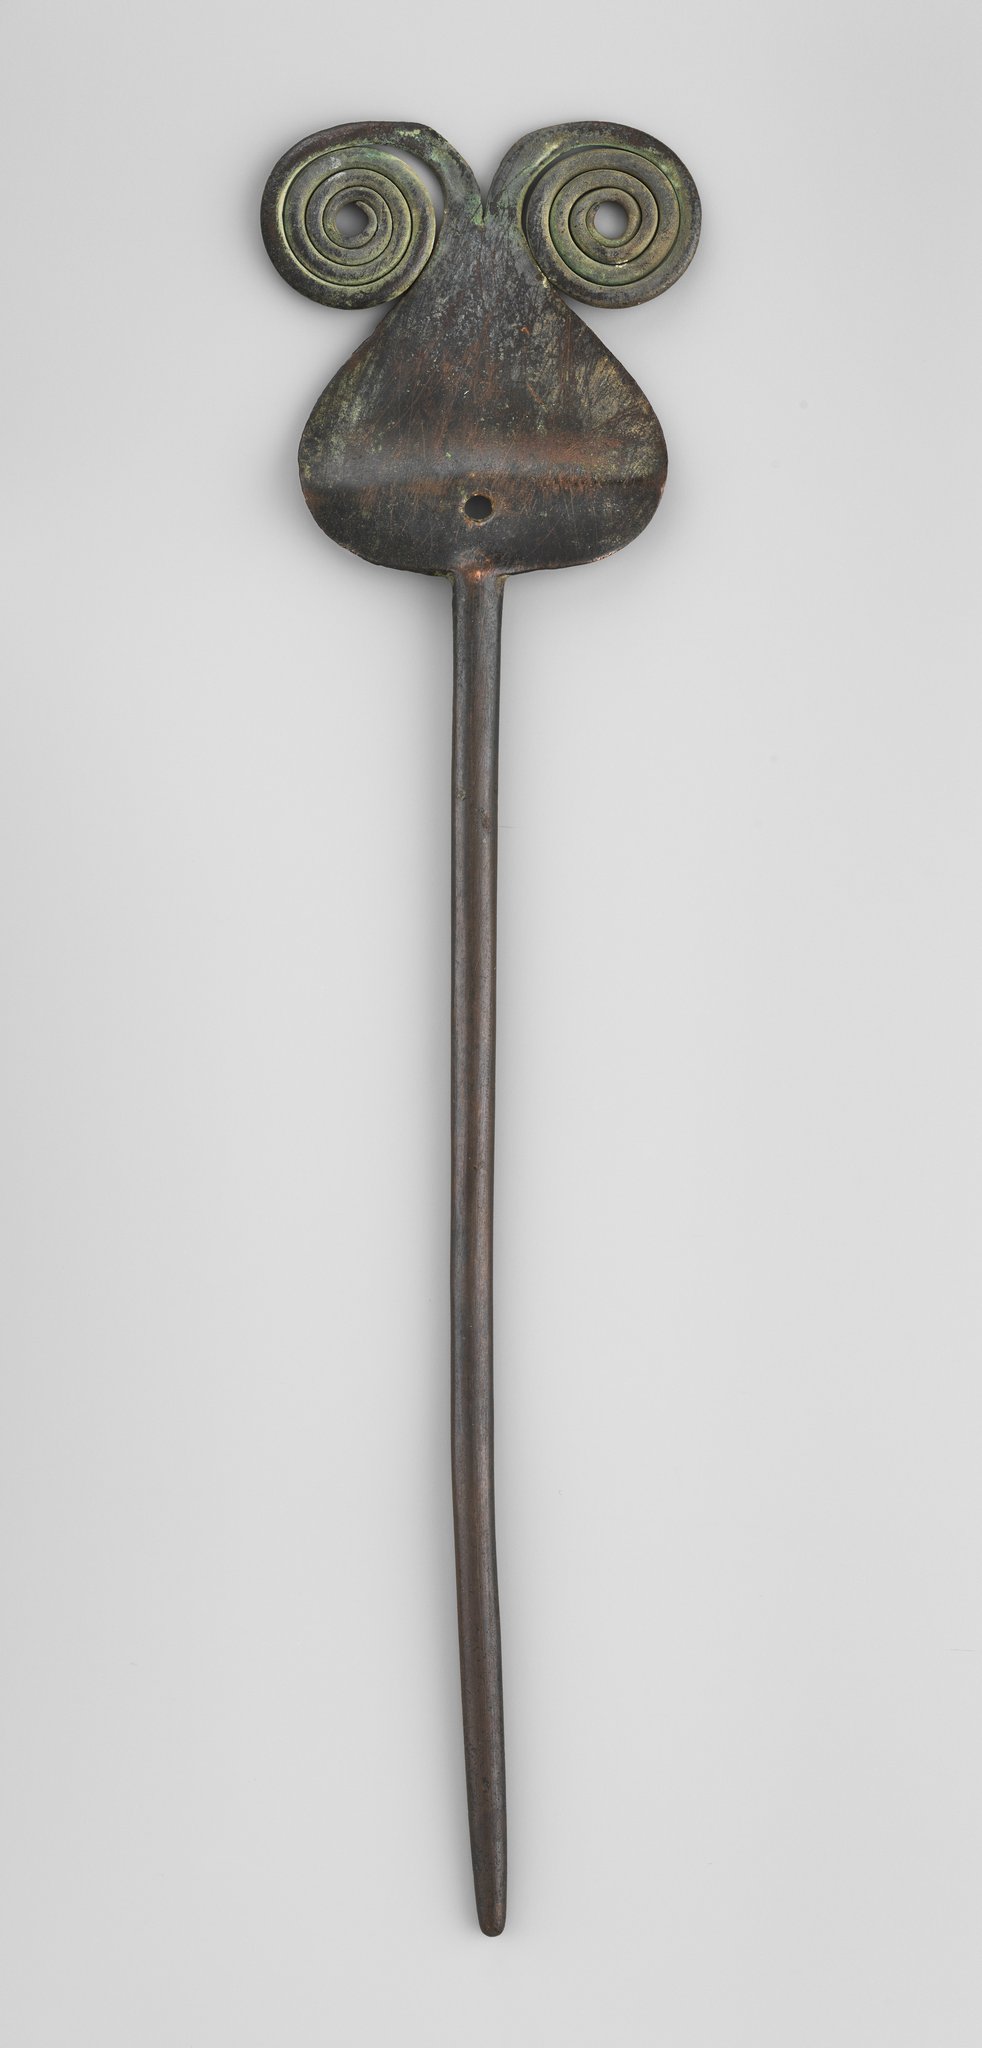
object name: pin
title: Tupu (pin)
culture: inca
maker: inca artist(s)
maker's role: artist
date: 1400-1535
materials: copper alloy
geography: peru